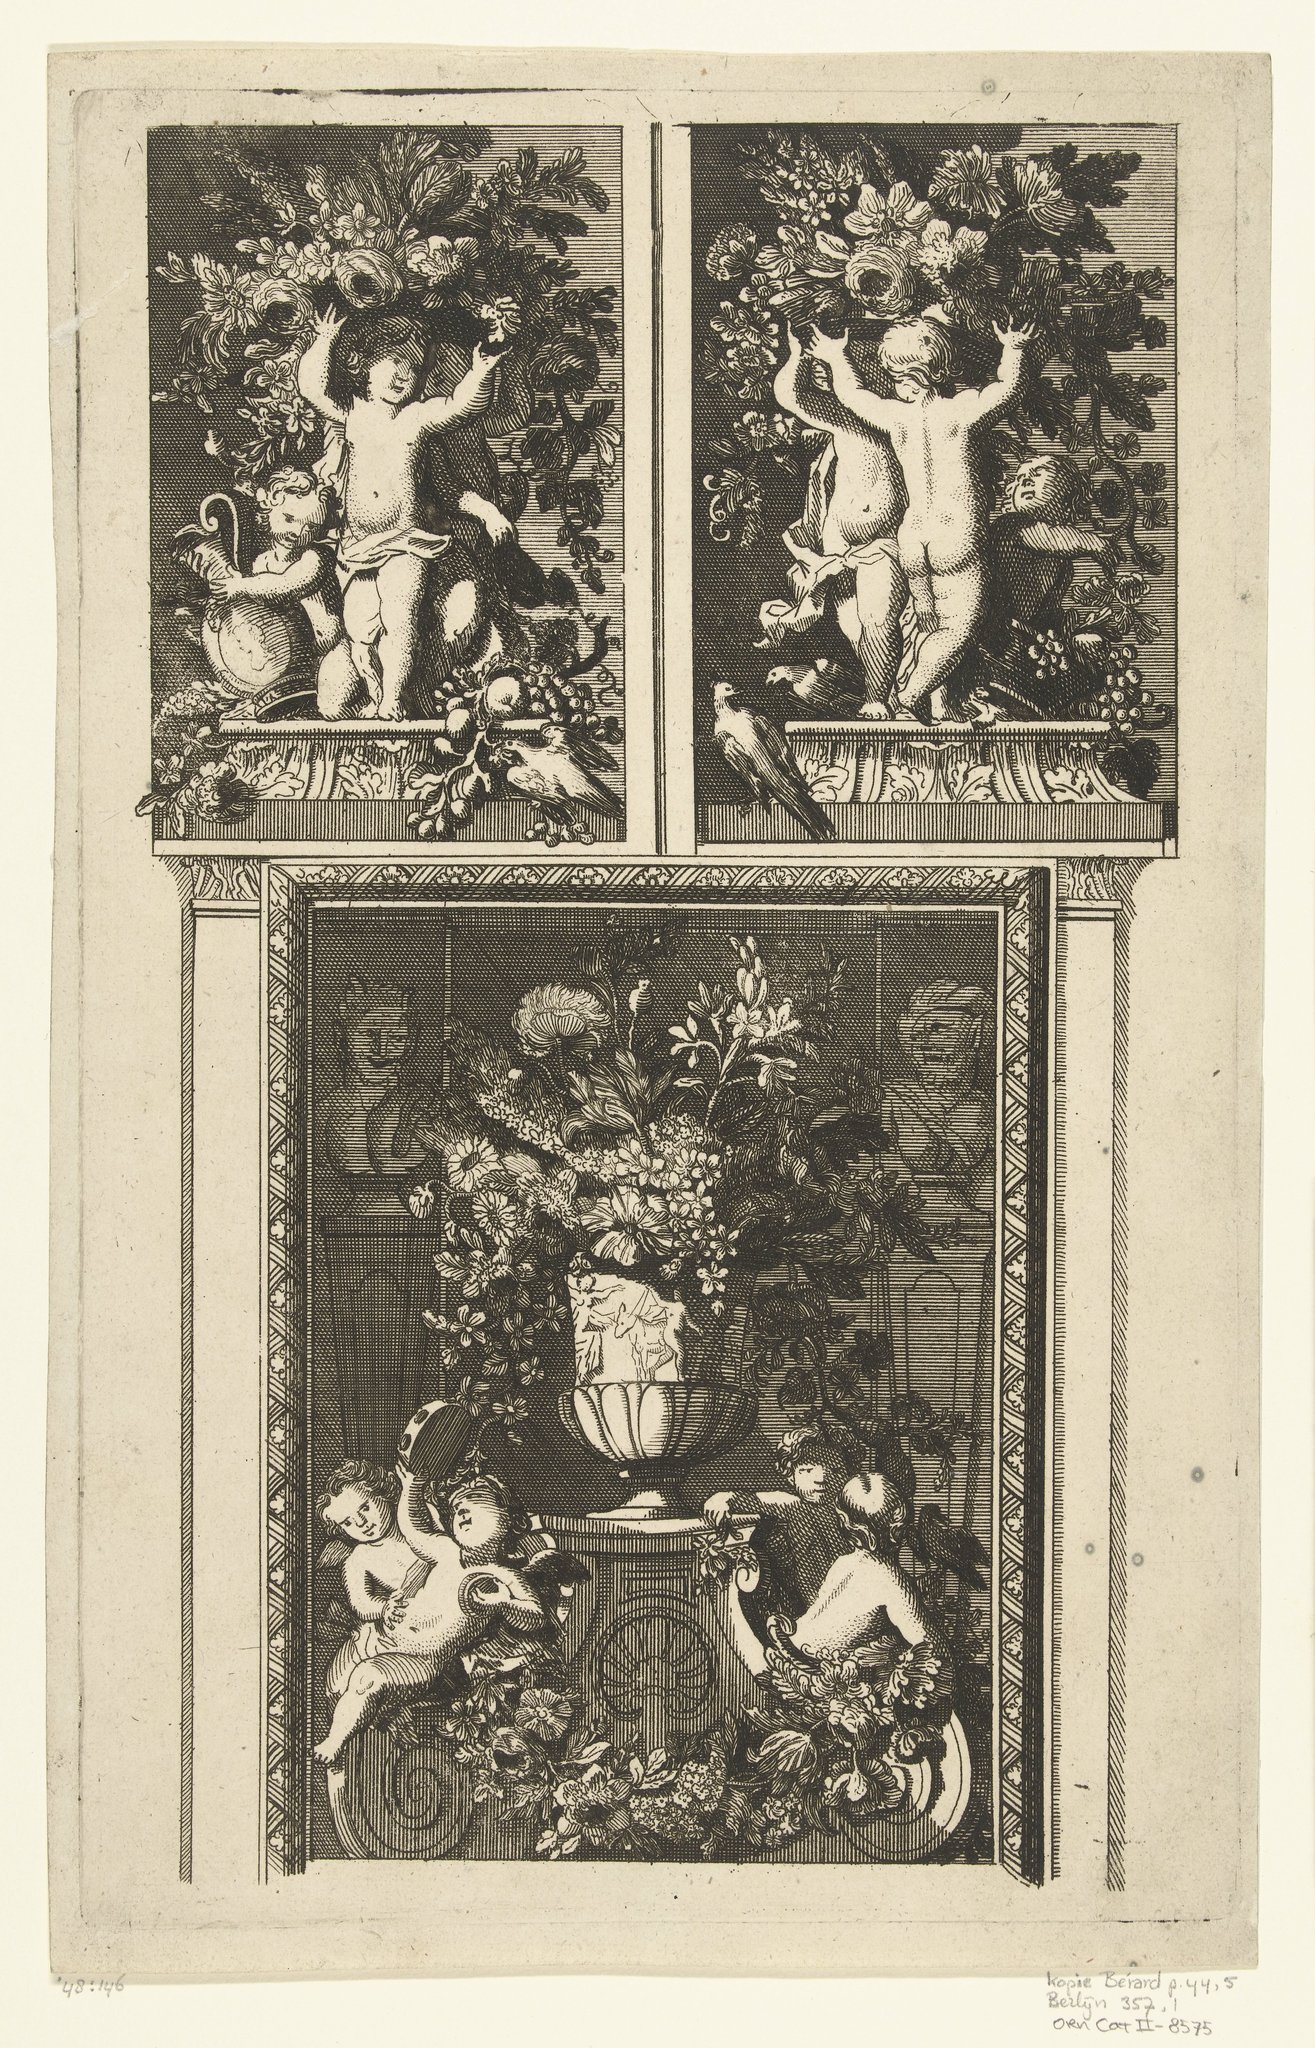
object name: ornament print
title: Twee dessus-de-portes en een schoorsteenstuk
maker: daniël marot (i)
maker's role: draughtsman, print maker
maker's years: 1661-1752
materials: paper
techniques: etching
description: Drie panelen. Links- en rechtsboven dragen putti een bloemenmand. Middenonder een vaas met bloemen op een voetstuk met vier putti. Kopie naar blad uit de serie Nouveaux Liure de Tableaux de Portes uitgegeven door Daniel Marot tussen 1703 en 1712.